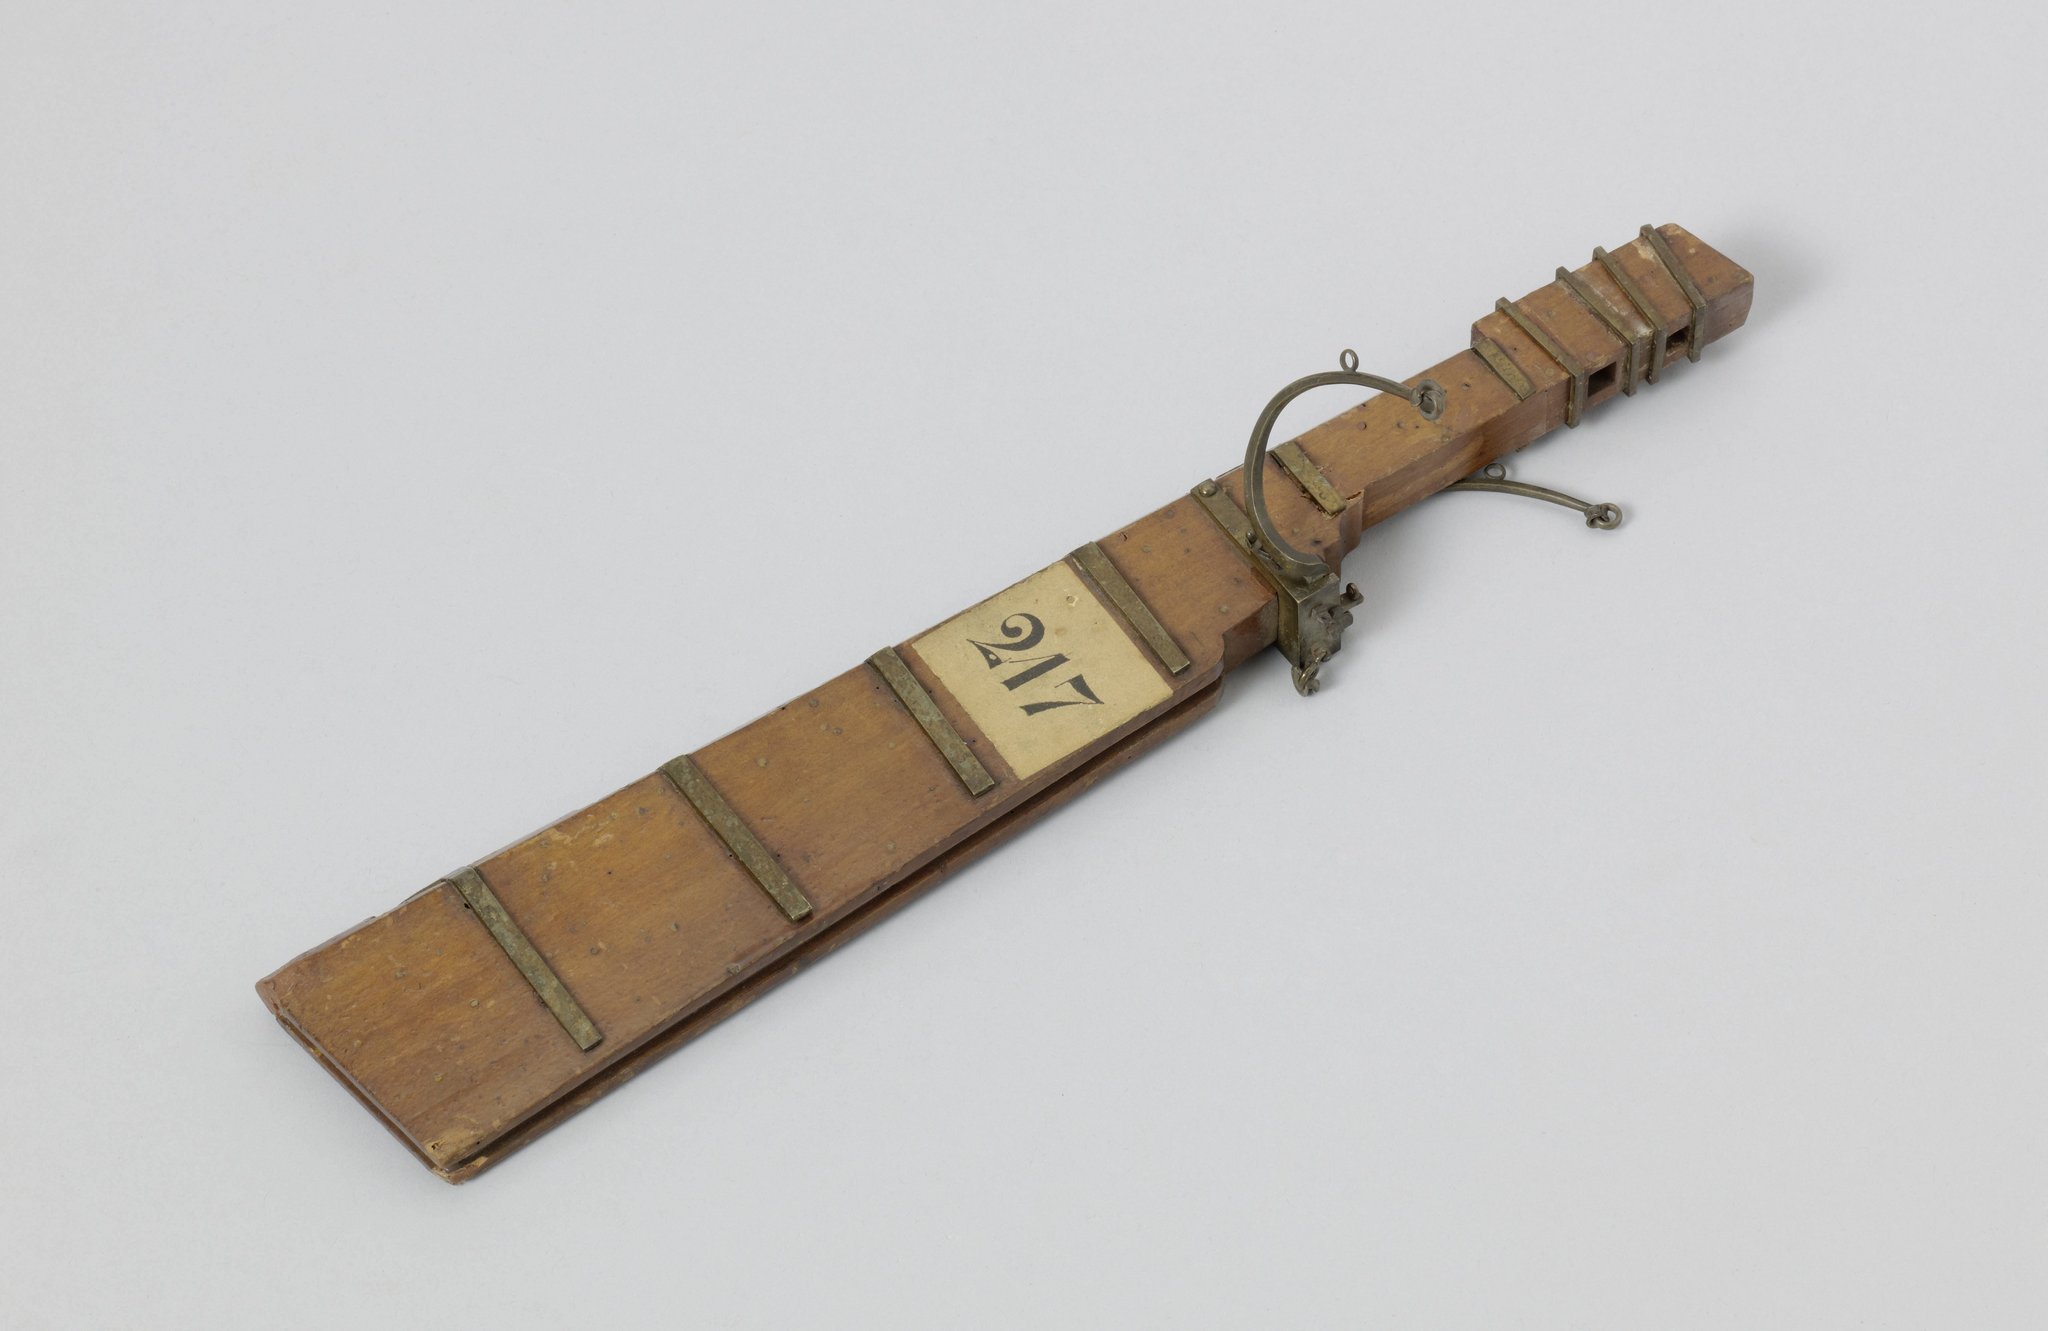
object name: demonstration model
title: Model of a Rudder to Be Steered with Tackles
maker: Anonymous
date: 1800-1840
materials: brass, wood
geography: netherlands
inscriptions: label, centre: ‘217’ former inventory label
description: Model van een roer met een vierkante roerkoning en twee gaten voor roerpennen. Het heeft zes roerhaken en het blad heeft zogklampen achterop en onderaan. Op de zorgband zijn twee uitklapbare gebogen messing stangen gemonteerd met ogen aan de uiteinden, waaraan de talies kunnen worden bevestigd die langszij naar het dek geleid worden. De zorgband heeft nog twee ogen, één met een aantal kettingschakels.